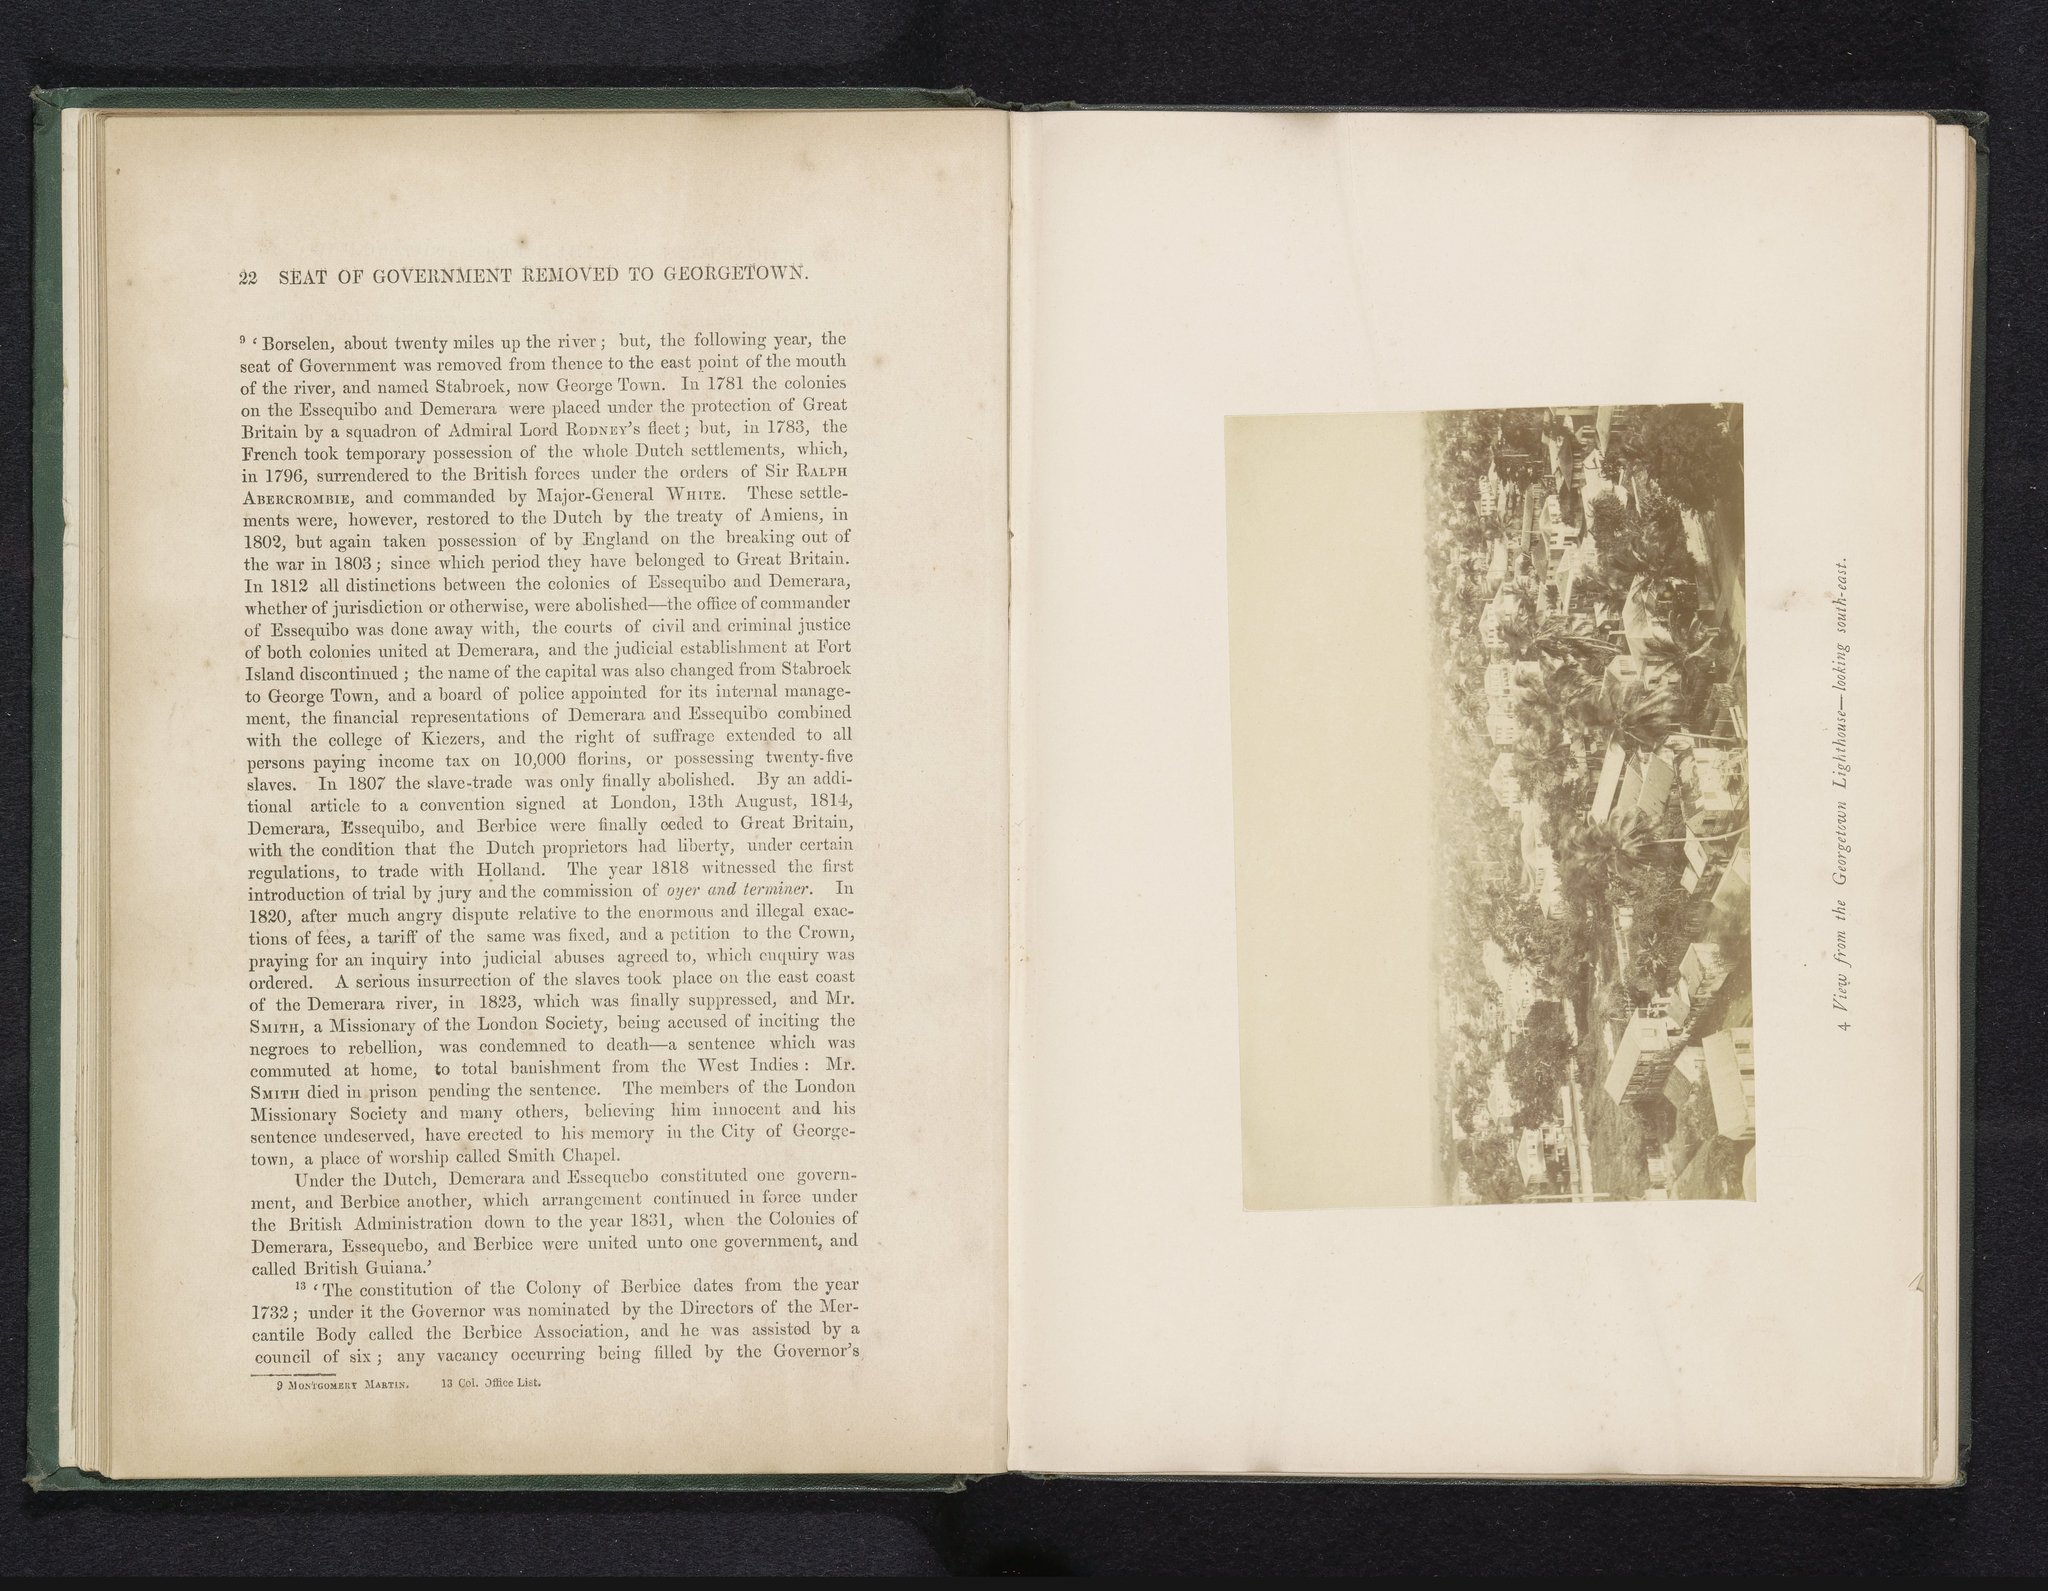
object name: photograph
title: Gezicht op Georgetown vanaf een vuurtoren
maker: Anonymous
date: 1856-1866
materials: photographic support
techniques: albumen print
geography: georgetown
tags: city-view, and landscape with man-made constructions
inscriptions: number: ‘4’